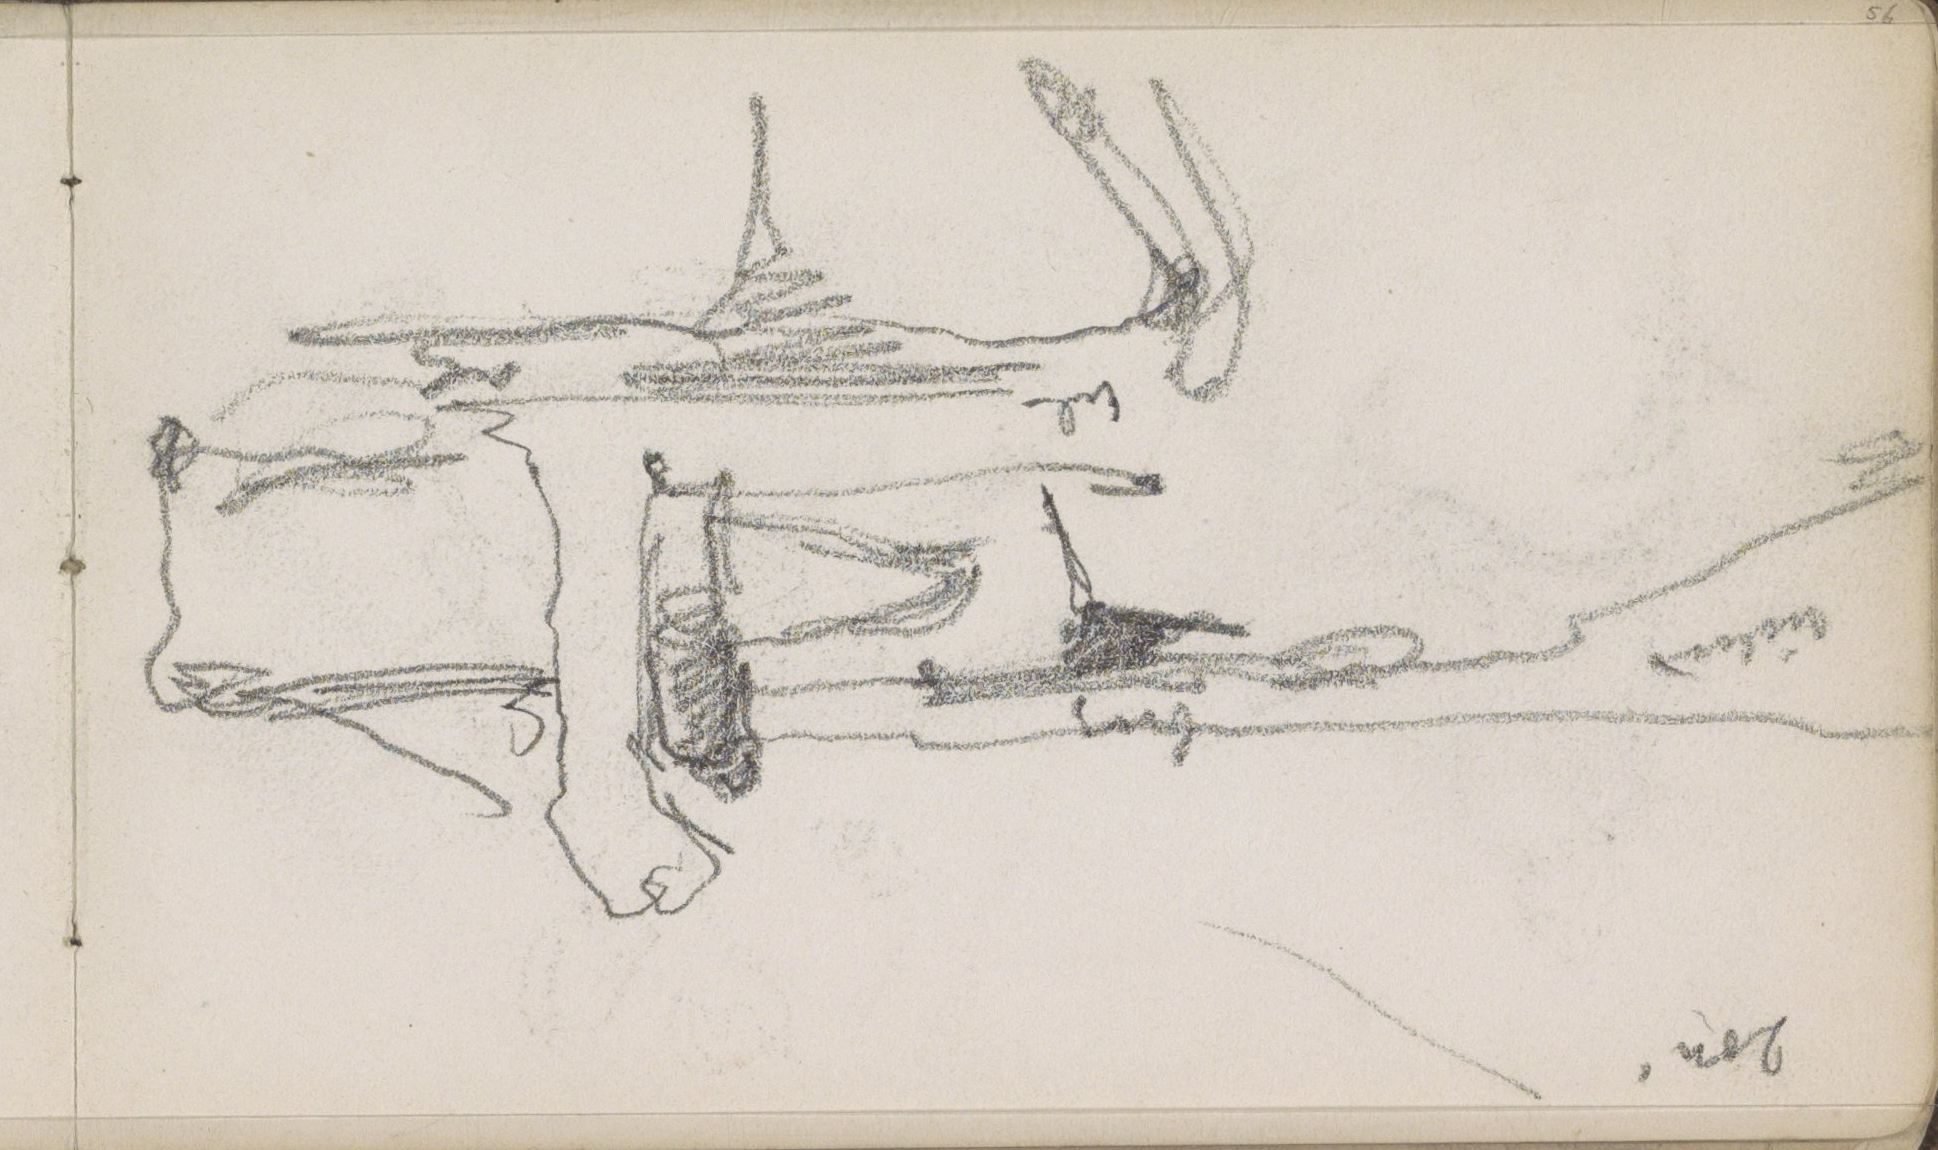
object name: sketchbook leaf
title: Rivierlandschap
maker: george hendrik breitner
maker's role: draughtsman, painter, print maker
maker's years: 1857-1923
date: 1881-1883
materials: paper, pencil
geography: north brabant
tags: river, bridge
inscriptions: annotation: ‘zon/ brug’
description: Pagina 56 uit een schetsboek met 42 bladen.